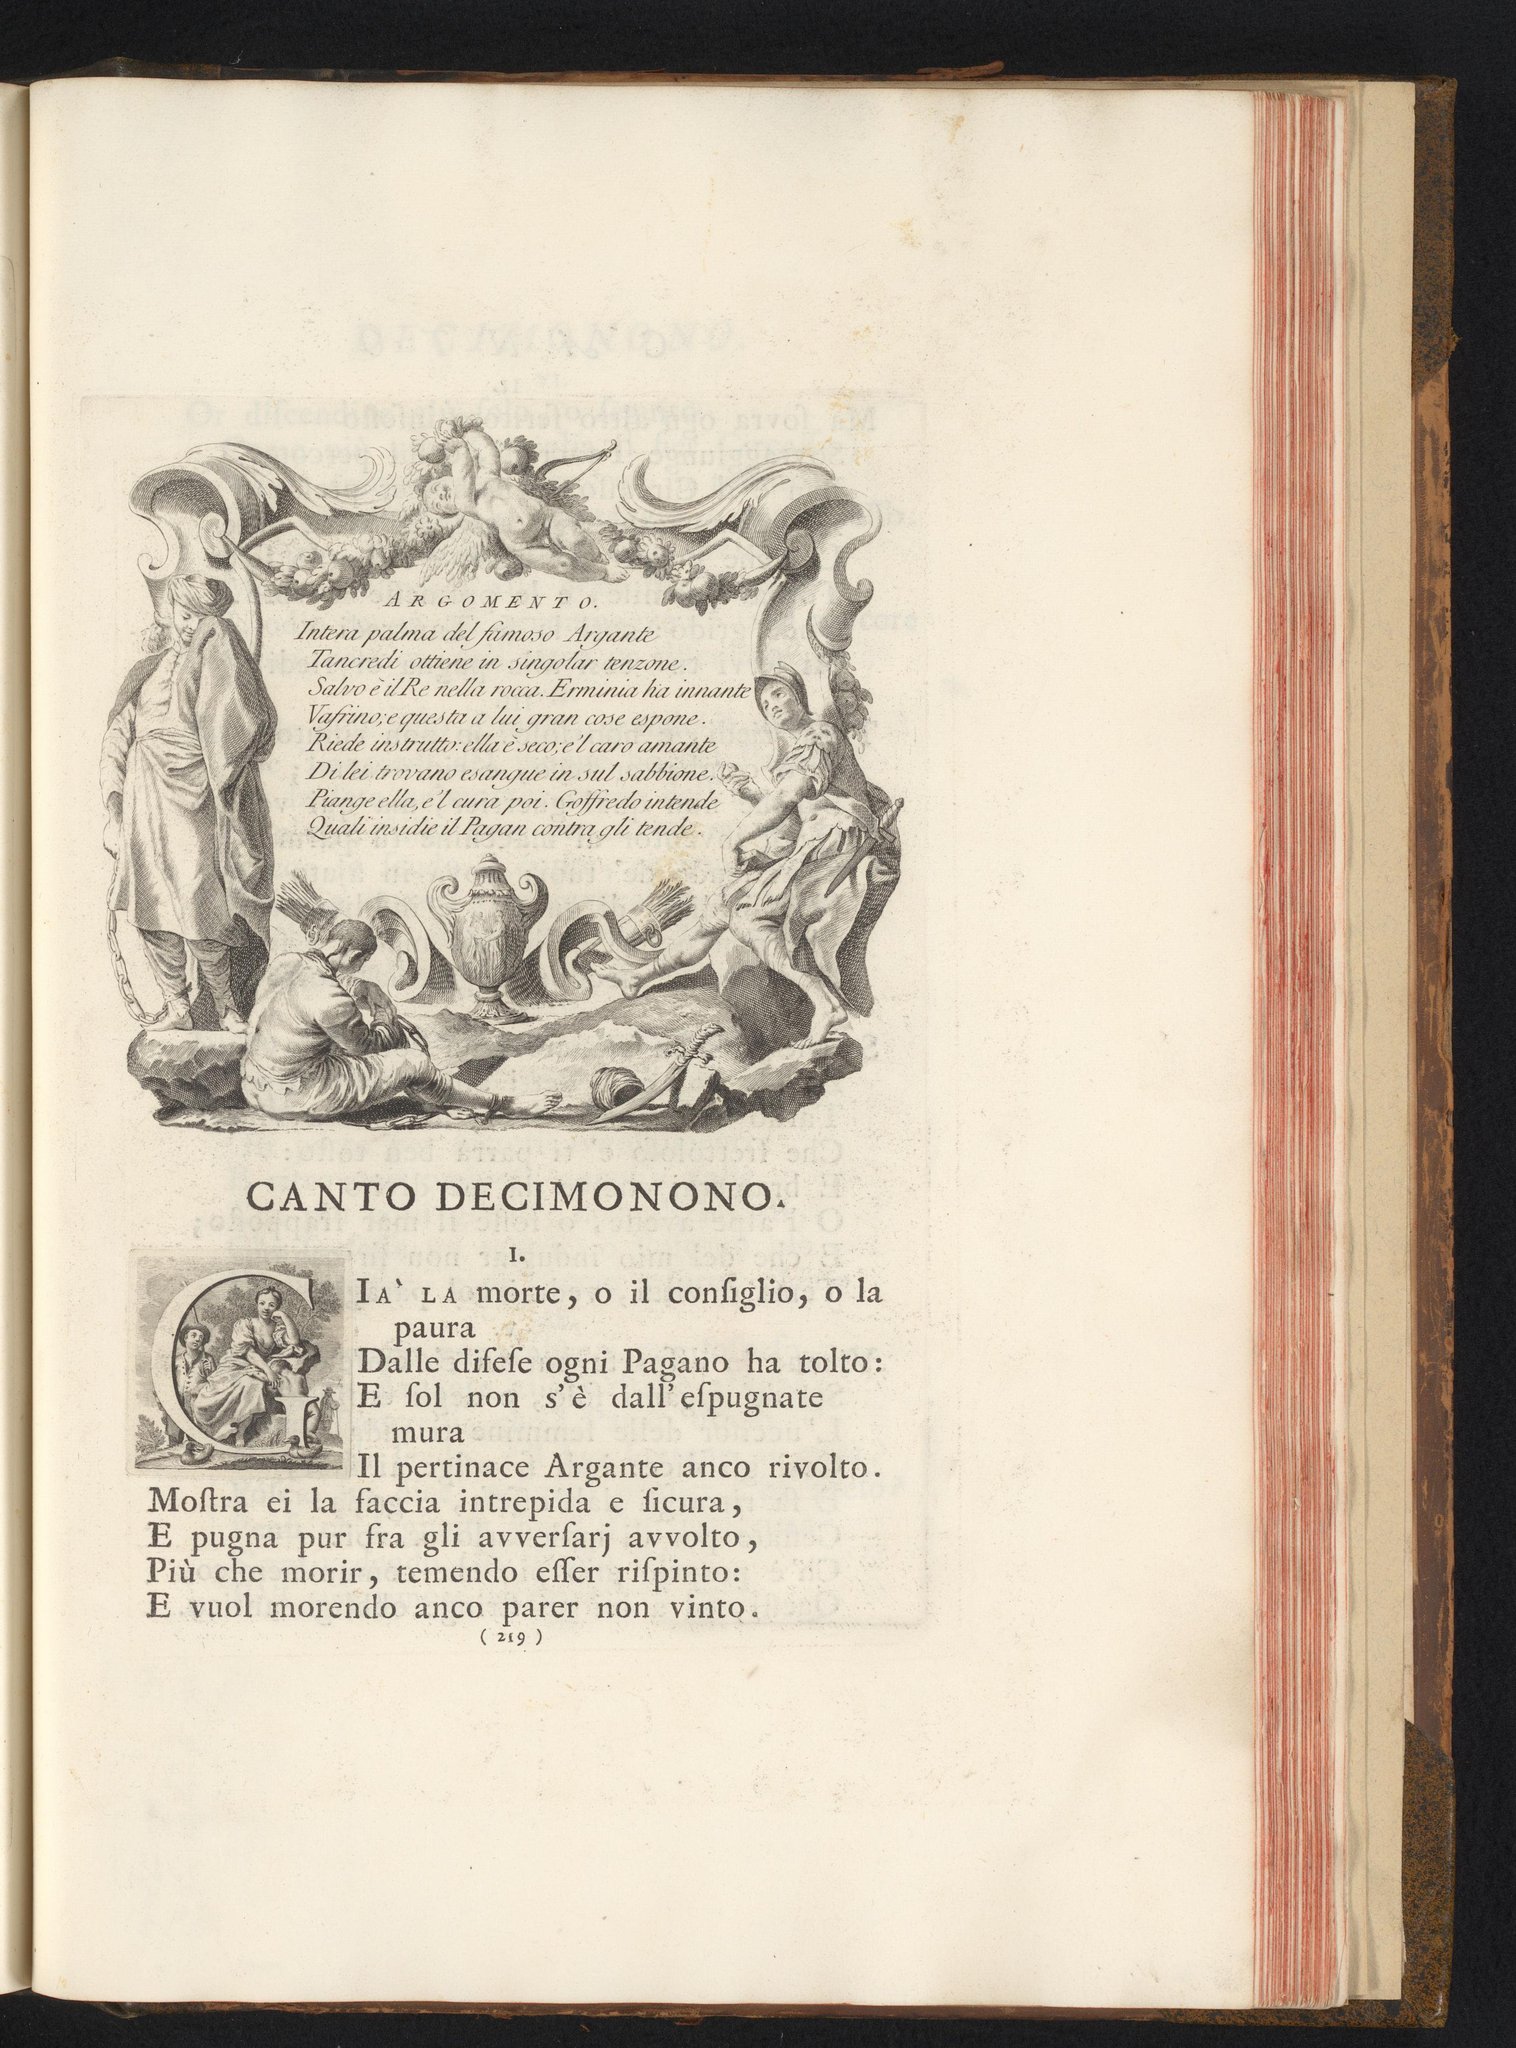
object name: print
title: Twee geketende mannen met wachter en initiaal G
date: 1745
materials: paper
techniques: etching, letterpress printing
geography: venice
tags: initial, prisoner; in fetters, (scenes from) specific works of literature: tasso, gerusalemme liberata, guard duty, keeping sentry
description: Prent uit: Tasso, Torquato. La Gerusalemme liberata di Torquato Tasso con le figure de Giambatista Piazzetta. Venetië: Giambatista Albrizzi, 1745.